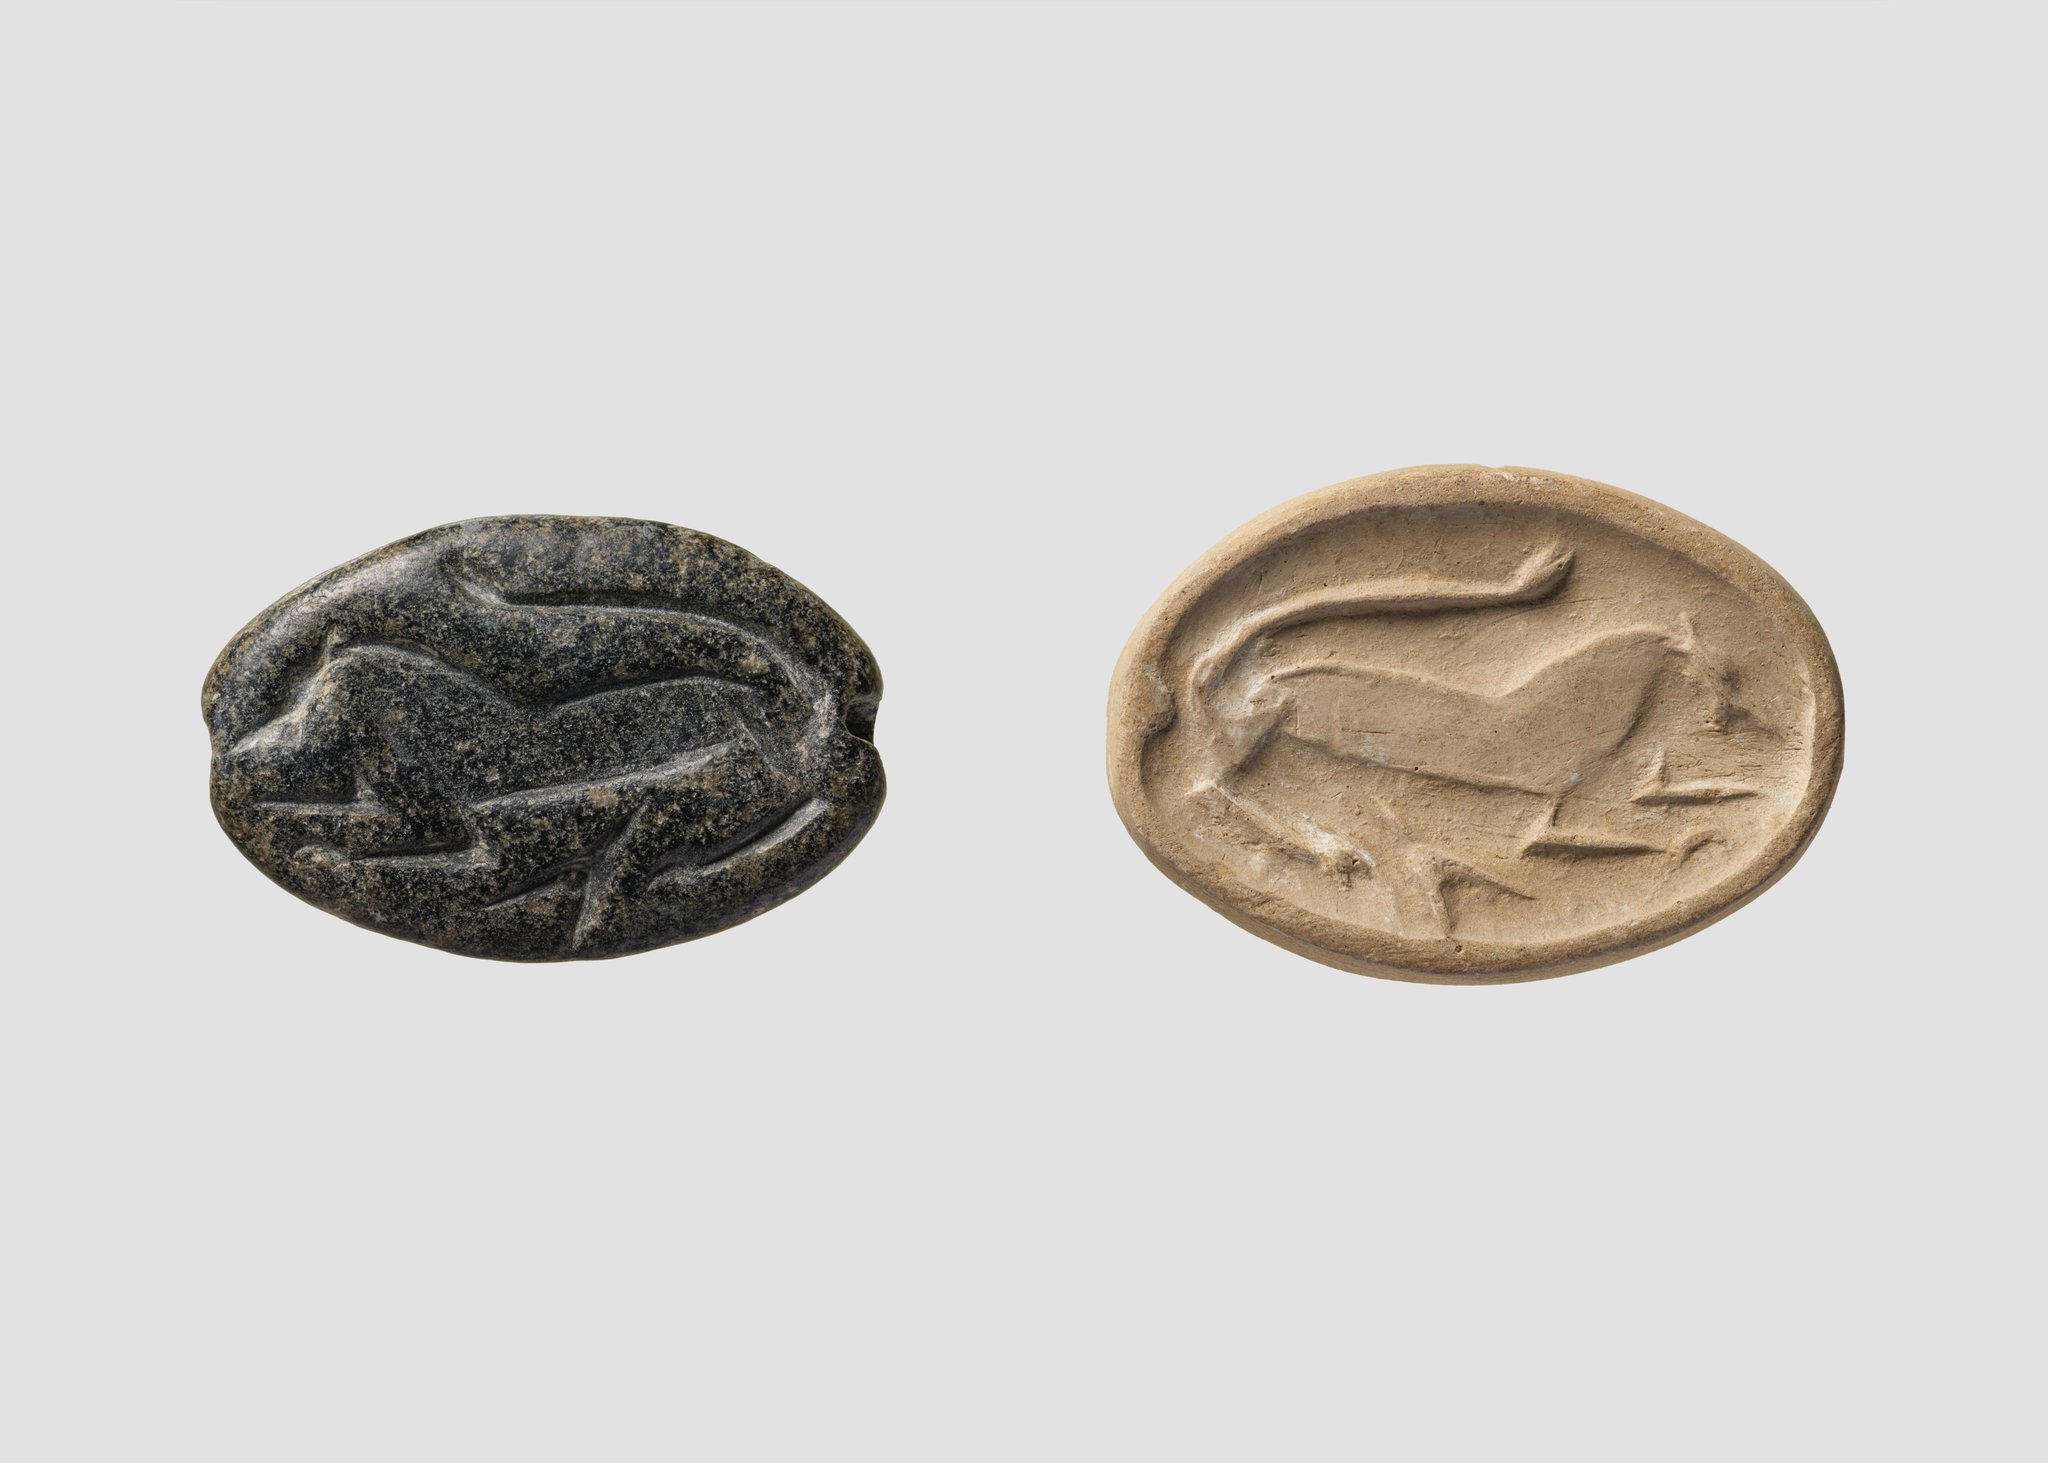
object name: stamp seal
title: Carinated amygdaloid seal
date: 4100-3500 BCE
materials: stone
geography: mesopotamia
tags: lions